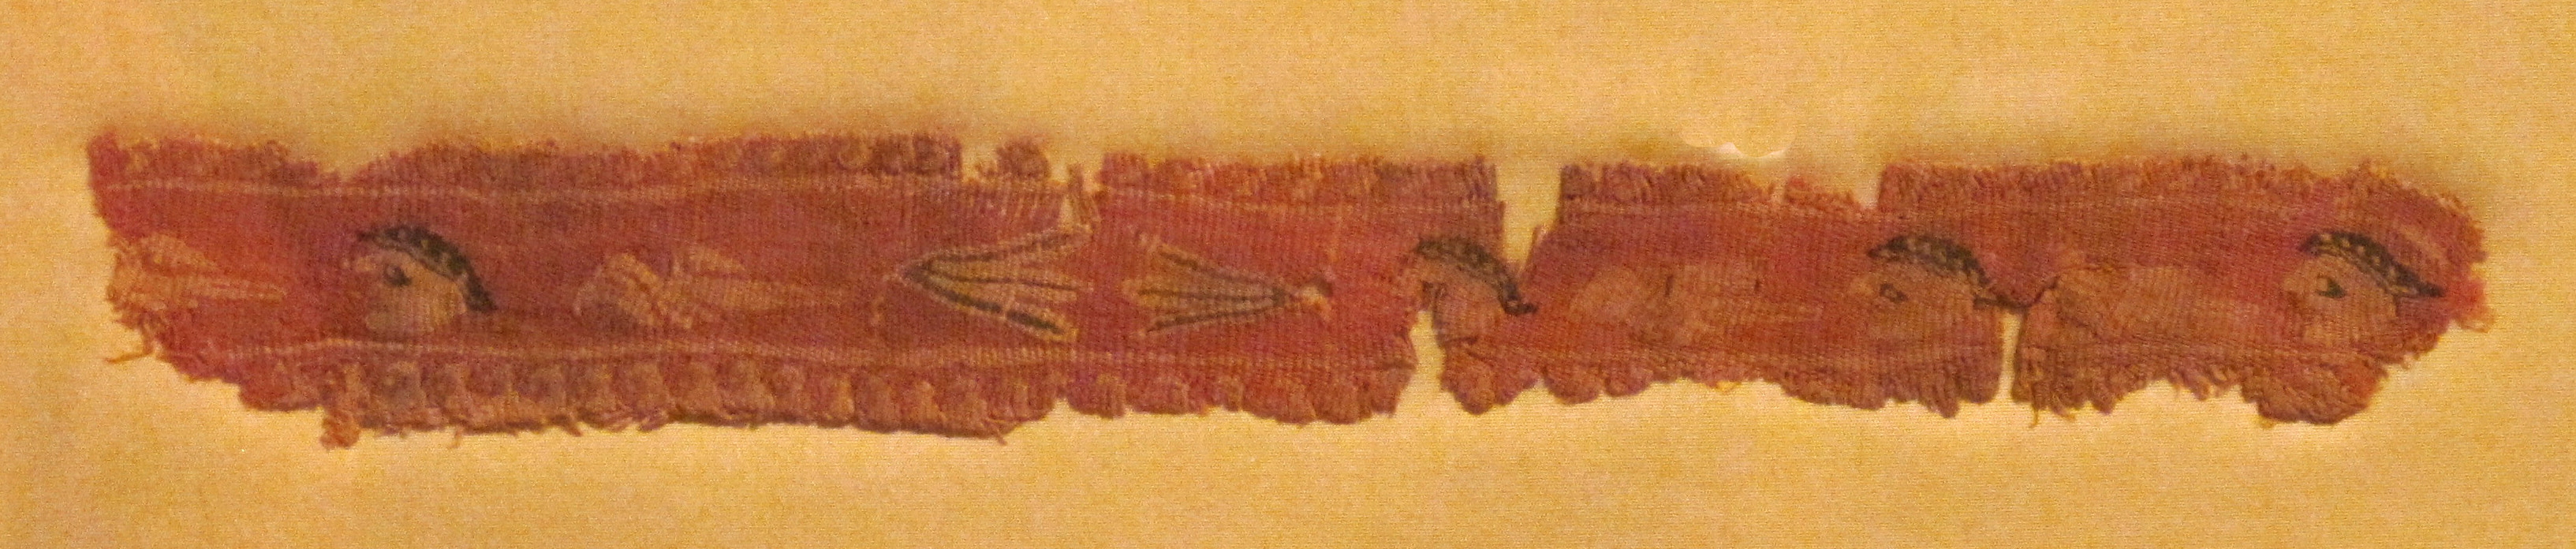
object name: textile fragment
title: Band Fragment with Masks, Lotus Flowers, and Birds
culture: coptic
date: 400-700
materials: linen, wool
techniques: polychrome, weave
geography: egypt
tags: birds,masks,lotuses